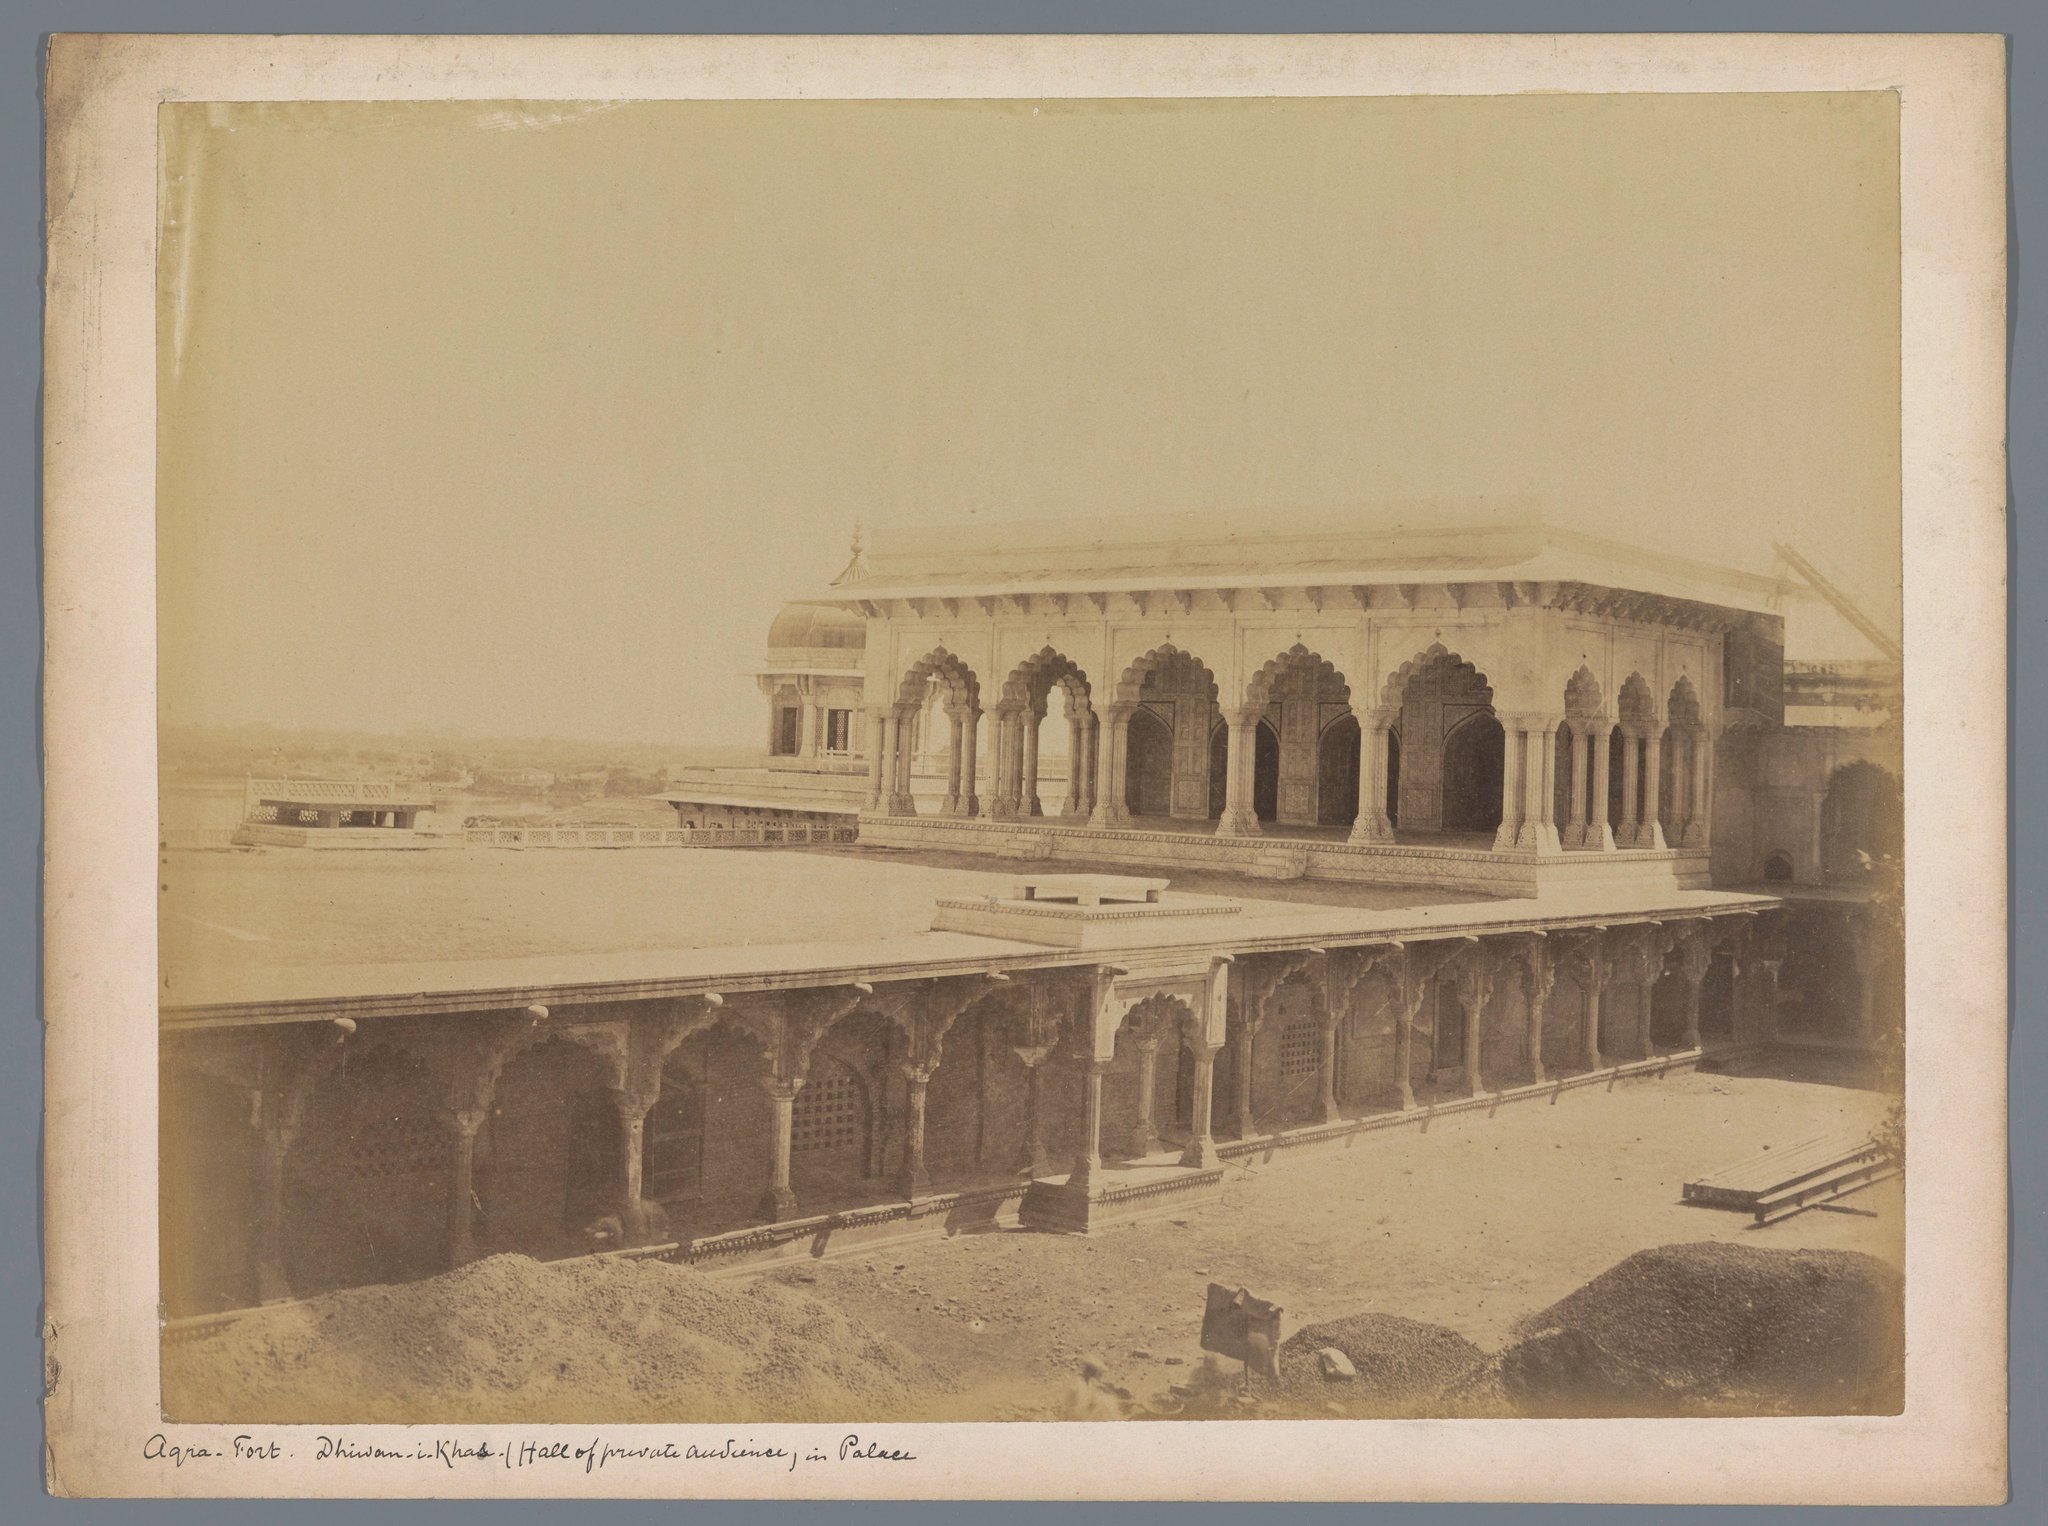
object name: photograph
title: View of the Diwan-i-Khas at Agra Fort, Uttar Pradesh, India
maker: Anonymous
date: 1860-1890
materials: cardboard, paper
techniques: albumen print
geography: agra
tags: palace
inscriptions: number: ‘45’, title: ‘Agra-Fort. Dhiwan-i-Khas -(Hall of private audience) in Palace’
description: Diwan-i-Khas was een privé-audiëntiezaal in een paleis of fort.